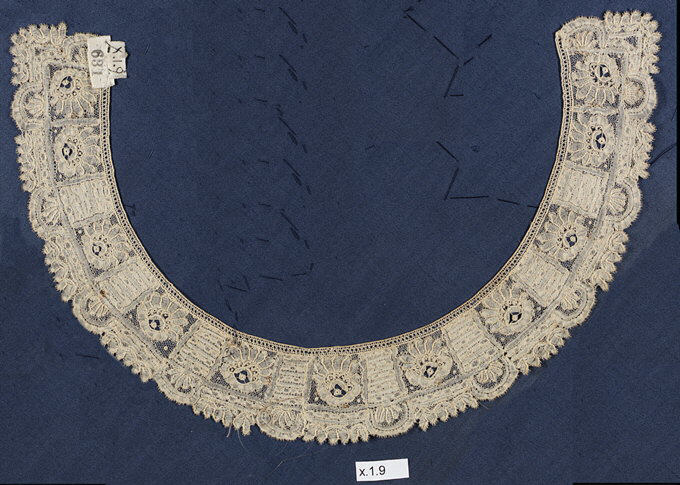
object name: collar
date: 1867-1900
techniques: lace